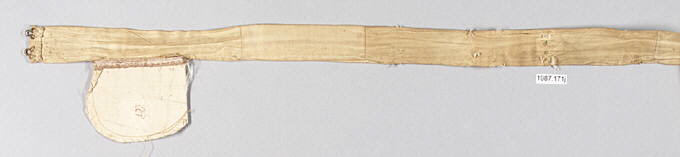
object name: waistband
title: Waistband (?)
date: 1750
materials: silk